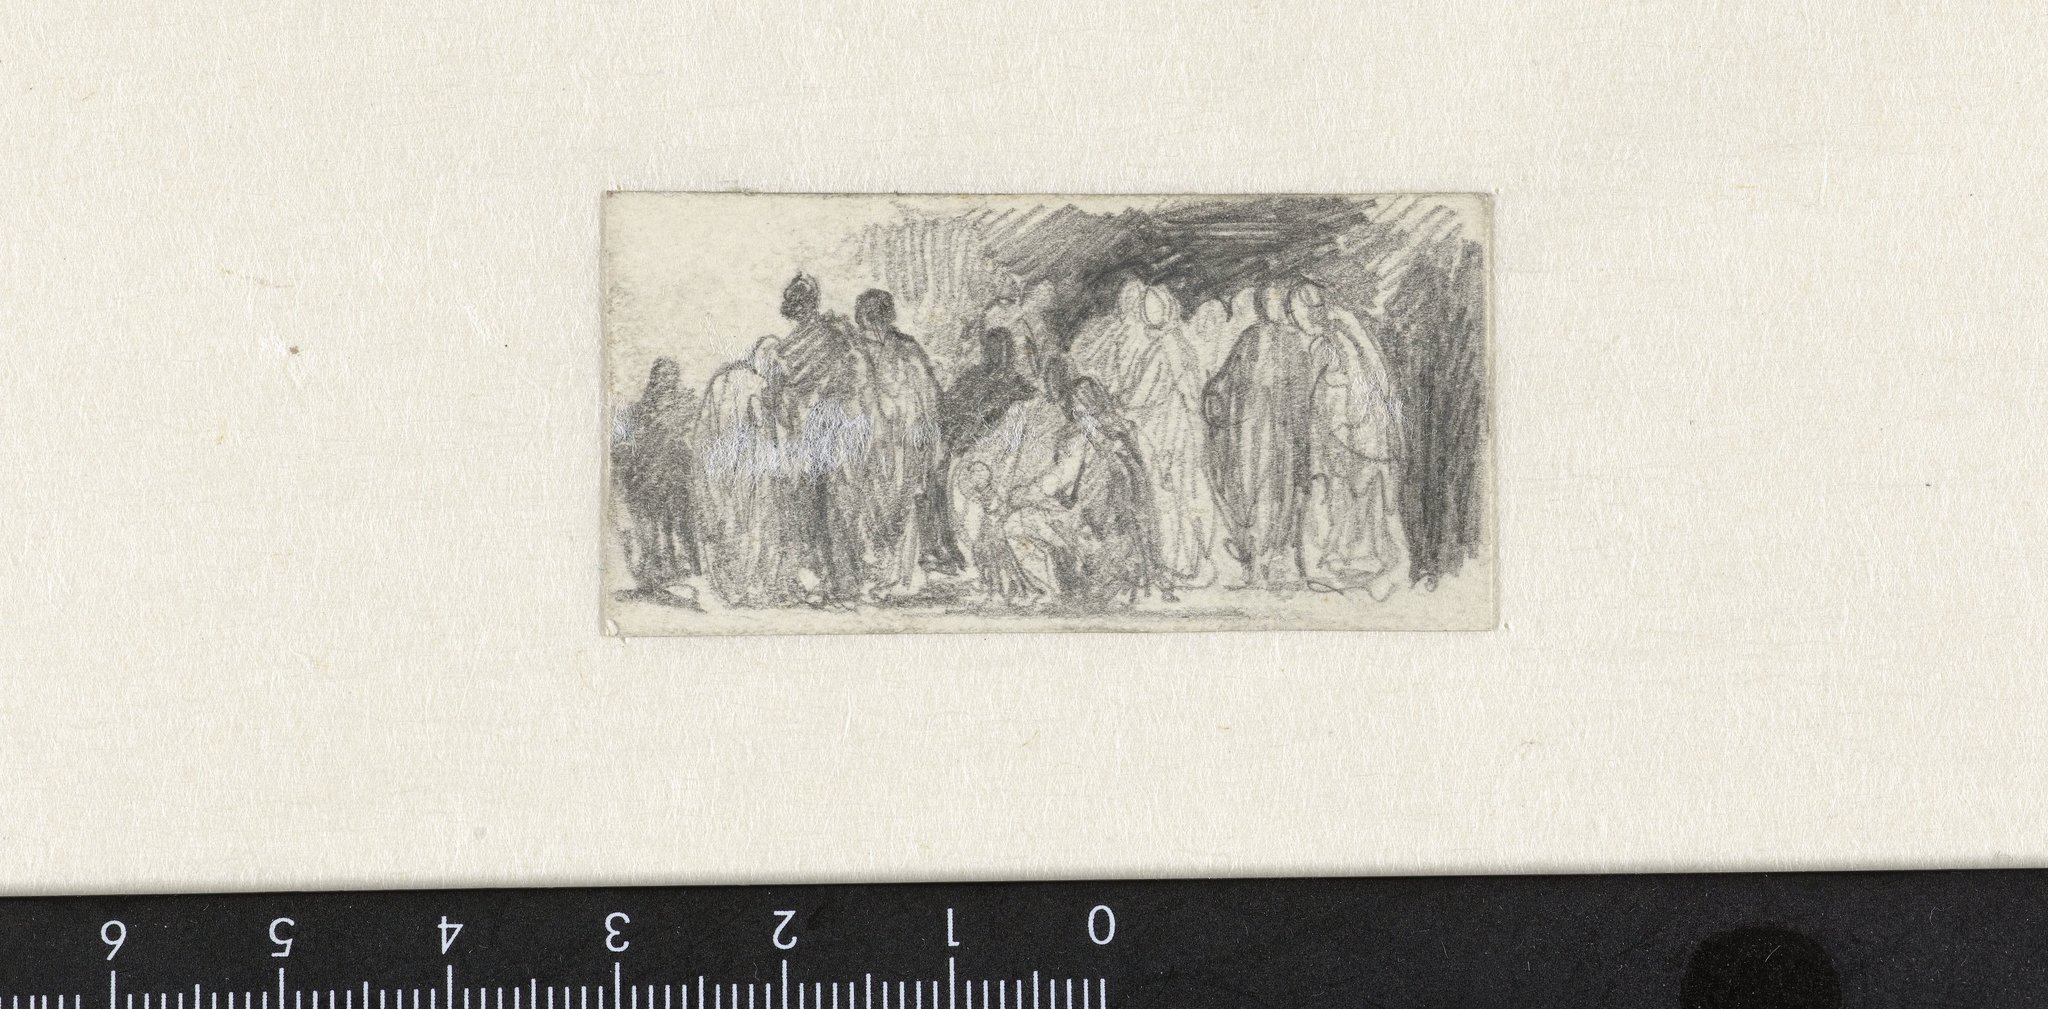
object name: drawing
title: Studie van een groep mensen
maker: johannes jacobus bertelman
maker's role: draughtsman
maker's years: 1821-1899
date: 1831-1899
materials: paper, pencil